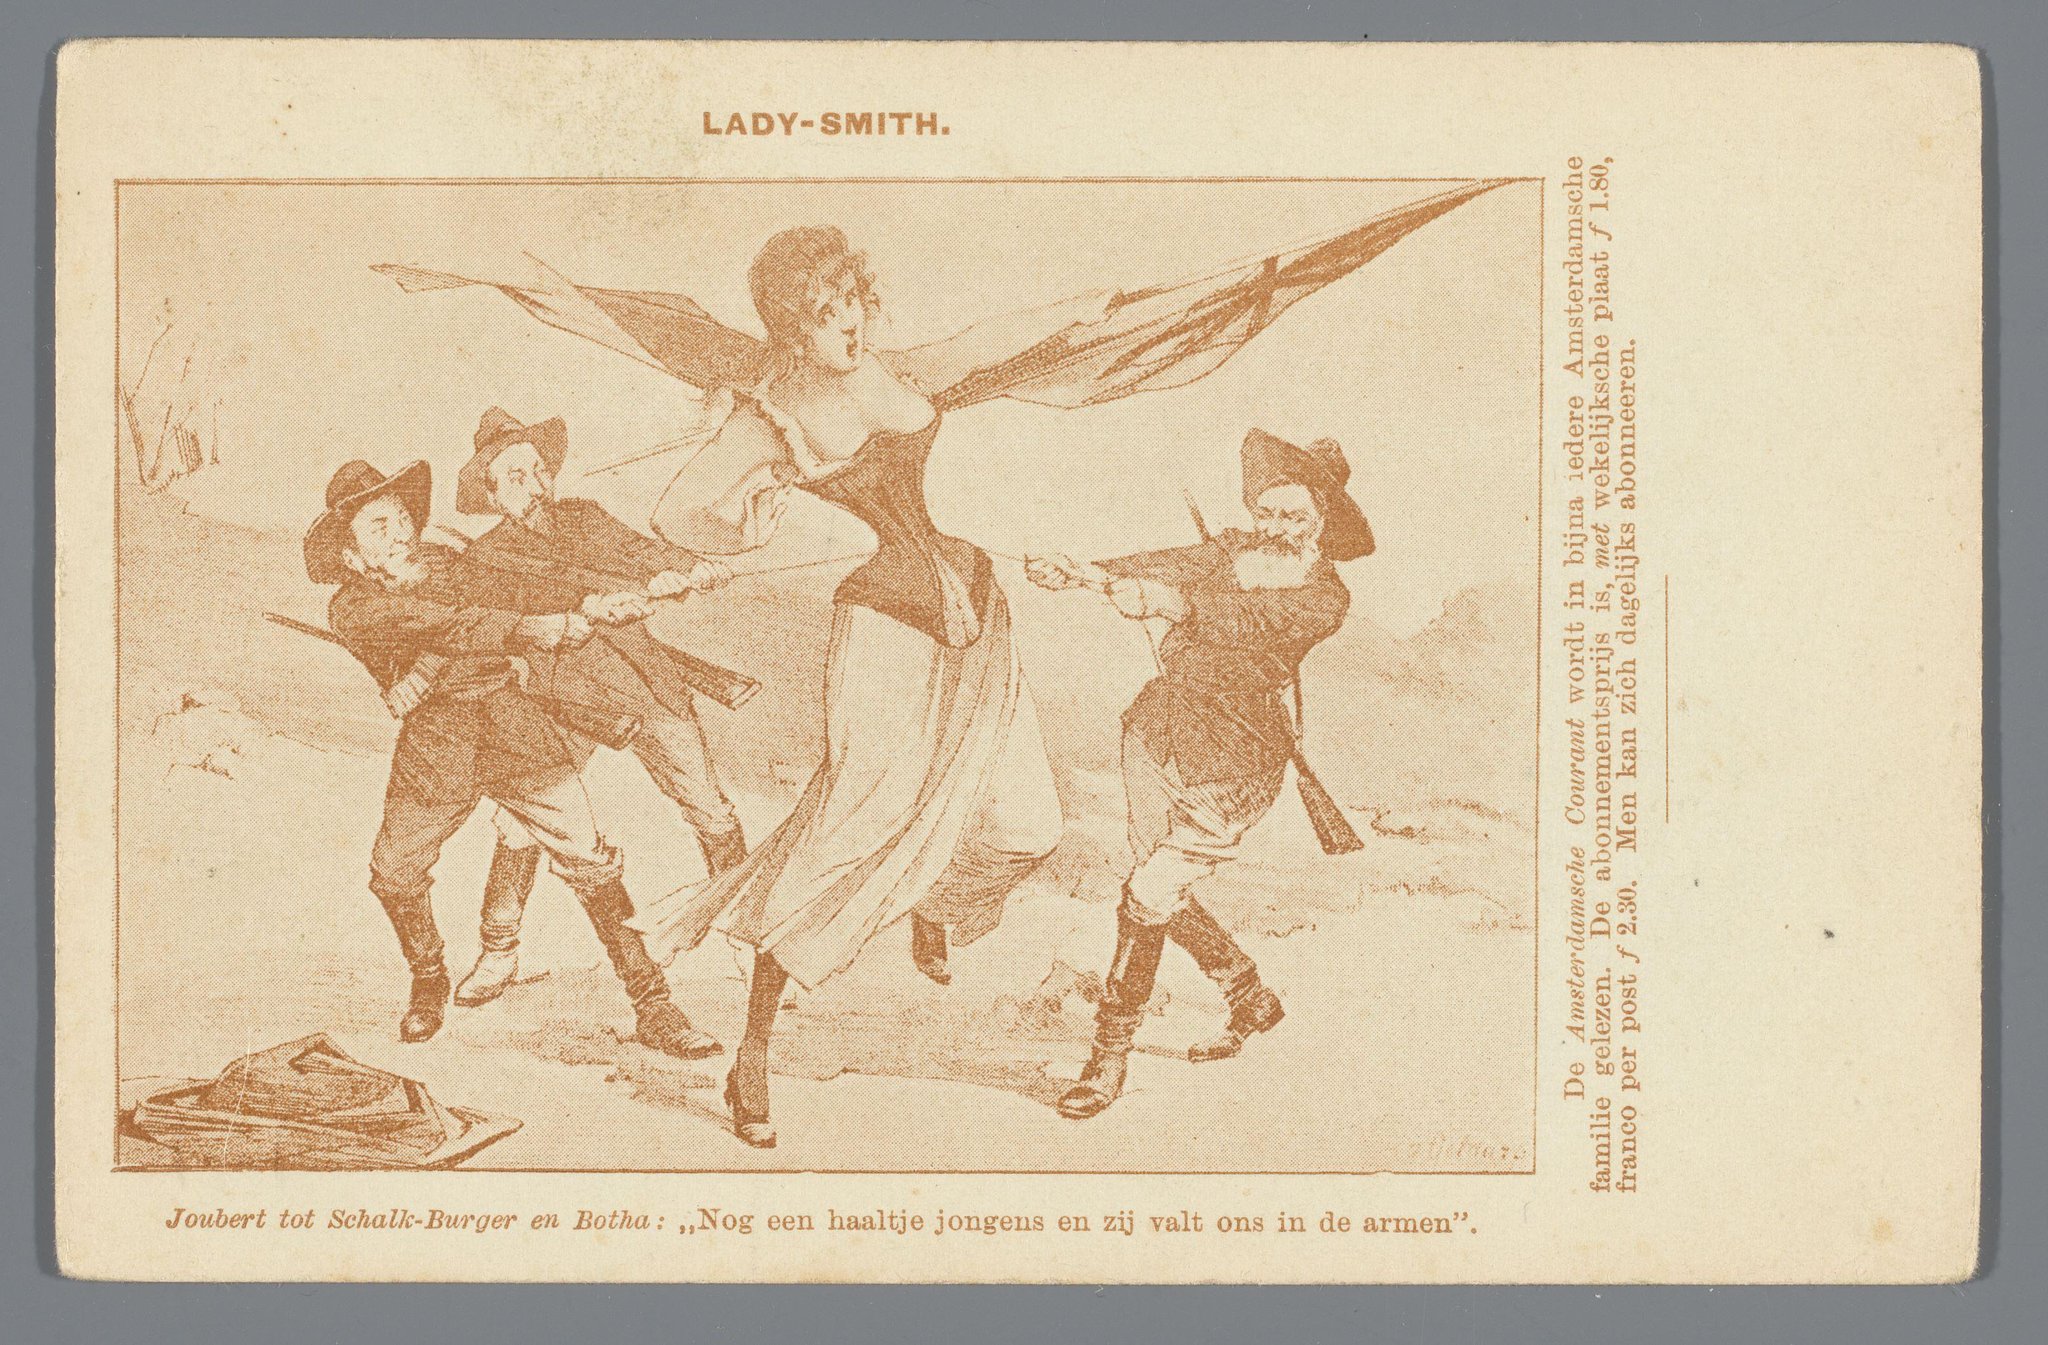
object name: ansichtkaart, prentbriefkaart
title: Boerenoorlog: Lady-Smith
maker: petrus van geldorp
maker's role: draughtsman, print maker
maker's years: 1872-1939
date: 1900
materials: paper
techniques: printing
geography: netherlands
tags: politician, netherlands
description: Boerenoorlog in Zuid-Afrika: Drie mannen trekken aan een dame = Lady-Smith (stad in Zuid Afrika ).Tekst onder de prent: Joubert tot Schalk-Burger en Botha: "Nog een haaltje jongens en zij valt ons in de armen"